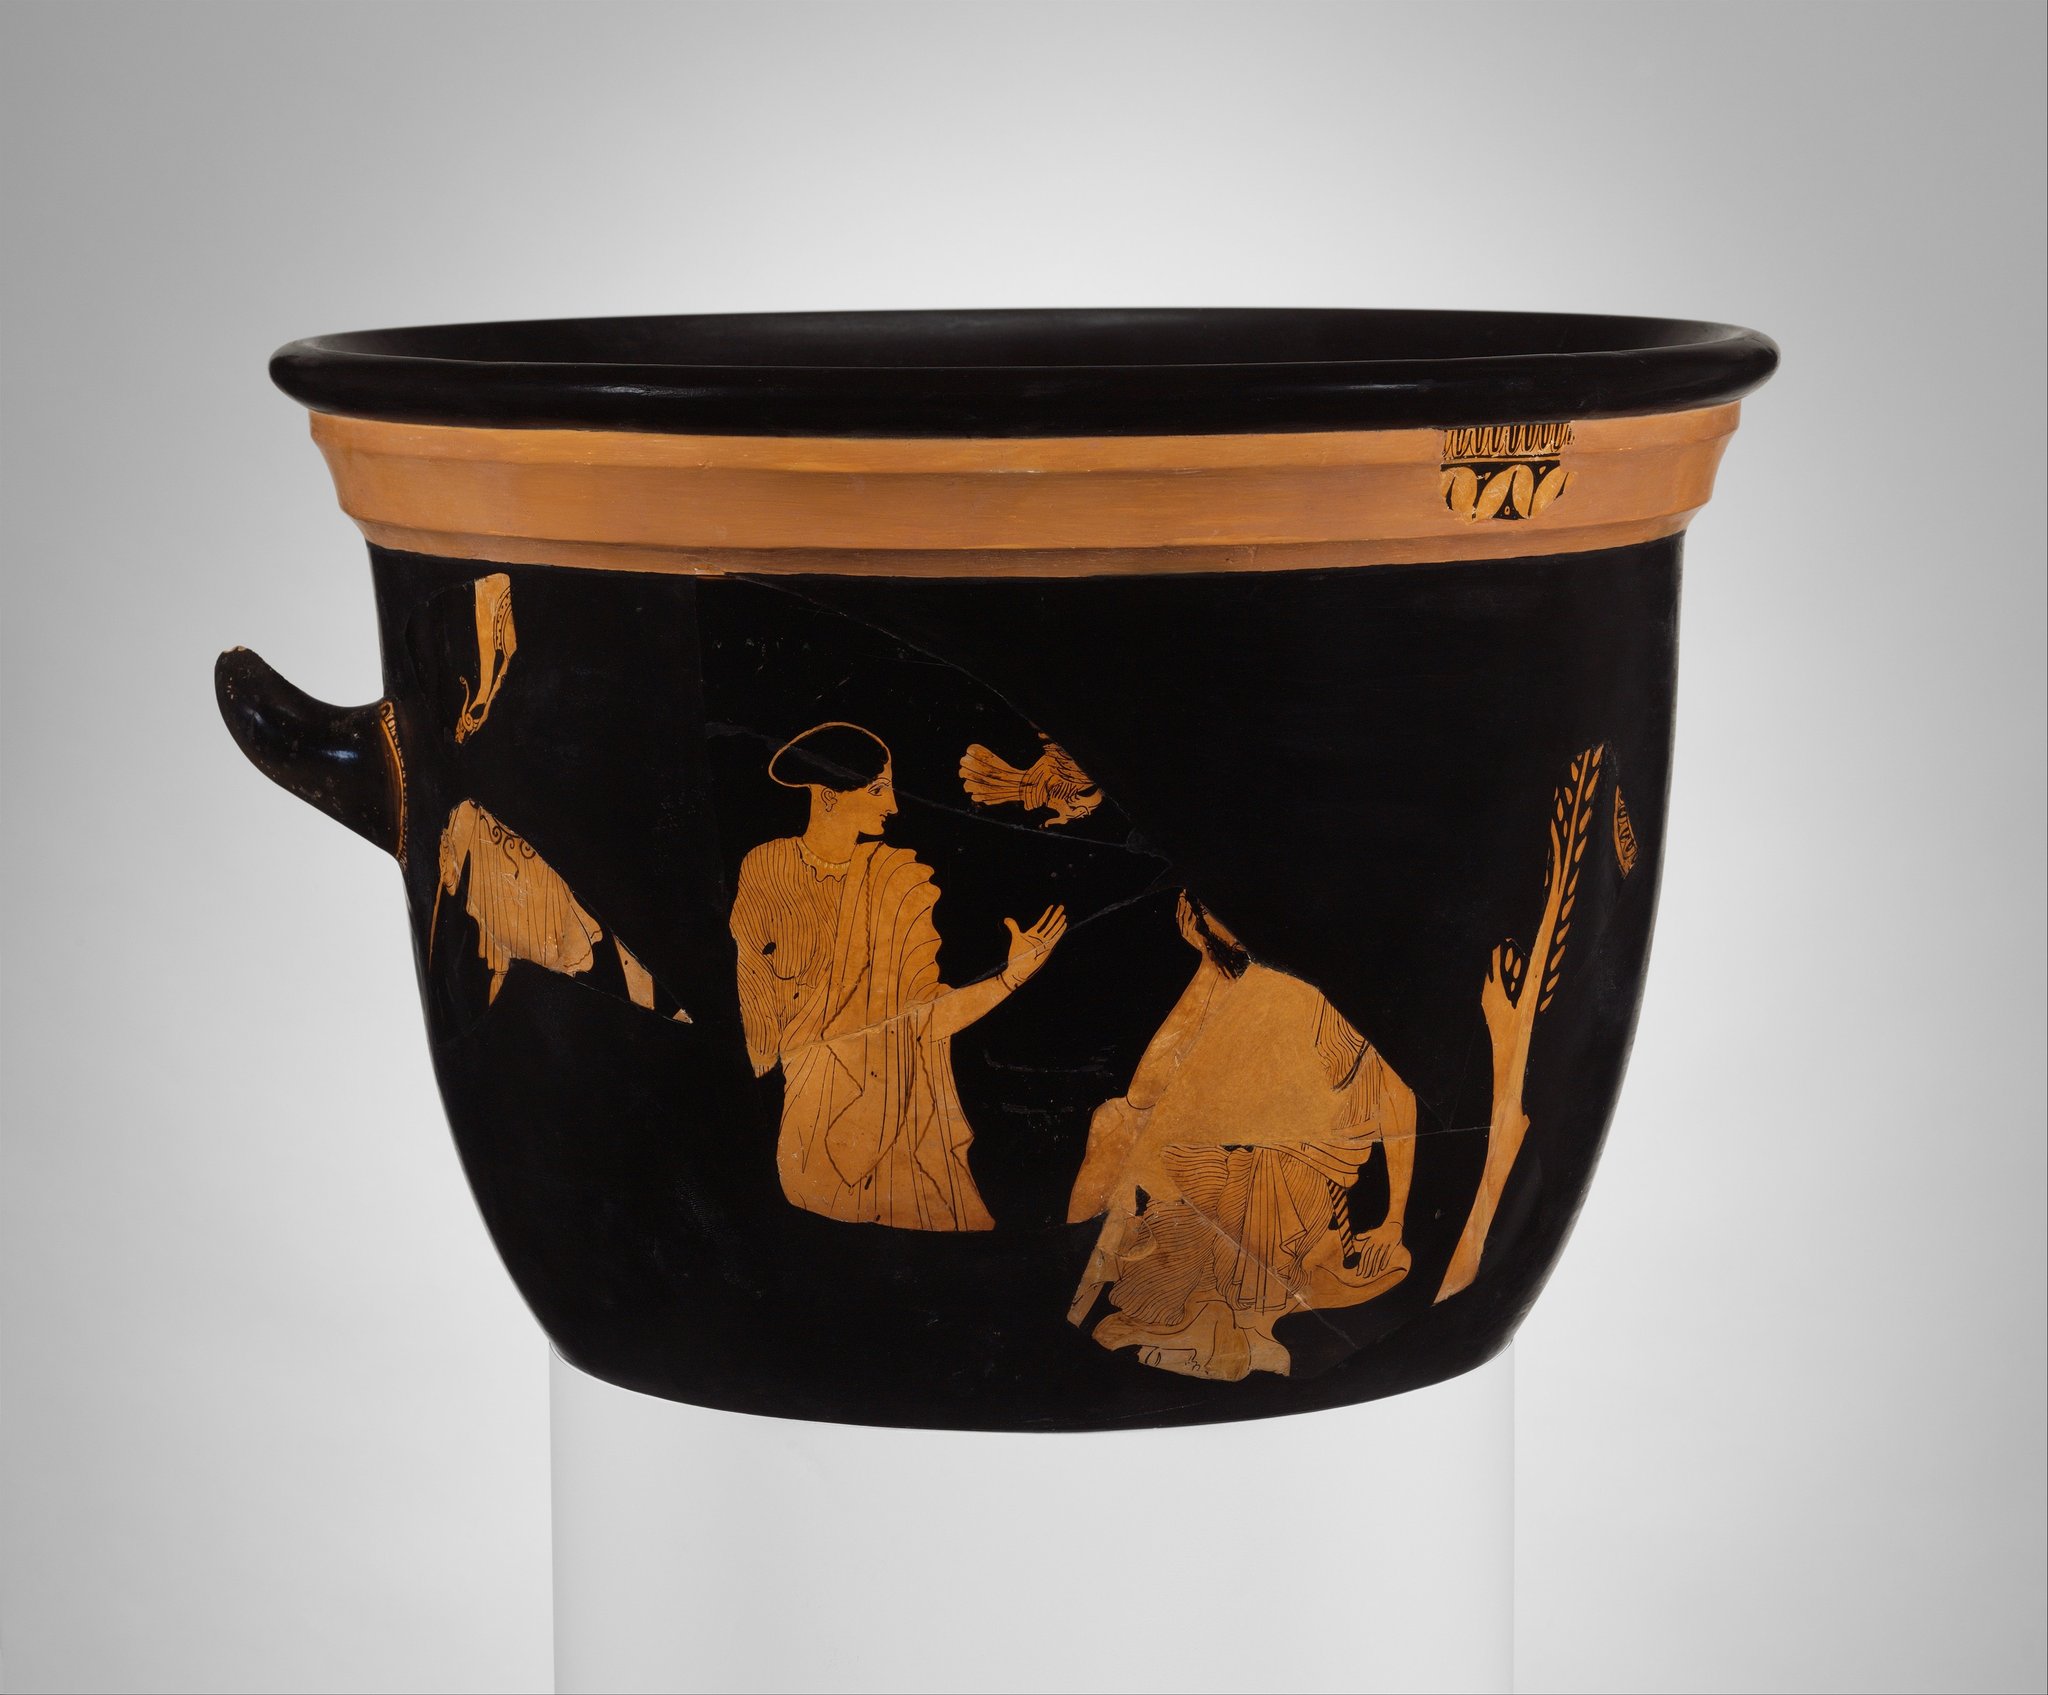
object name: bell krater fragment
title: Terracotta bell-krater (bowl for mixing wine and water)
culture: greek, attic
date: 440-430 BCE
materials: terracotta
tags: men,women,athena